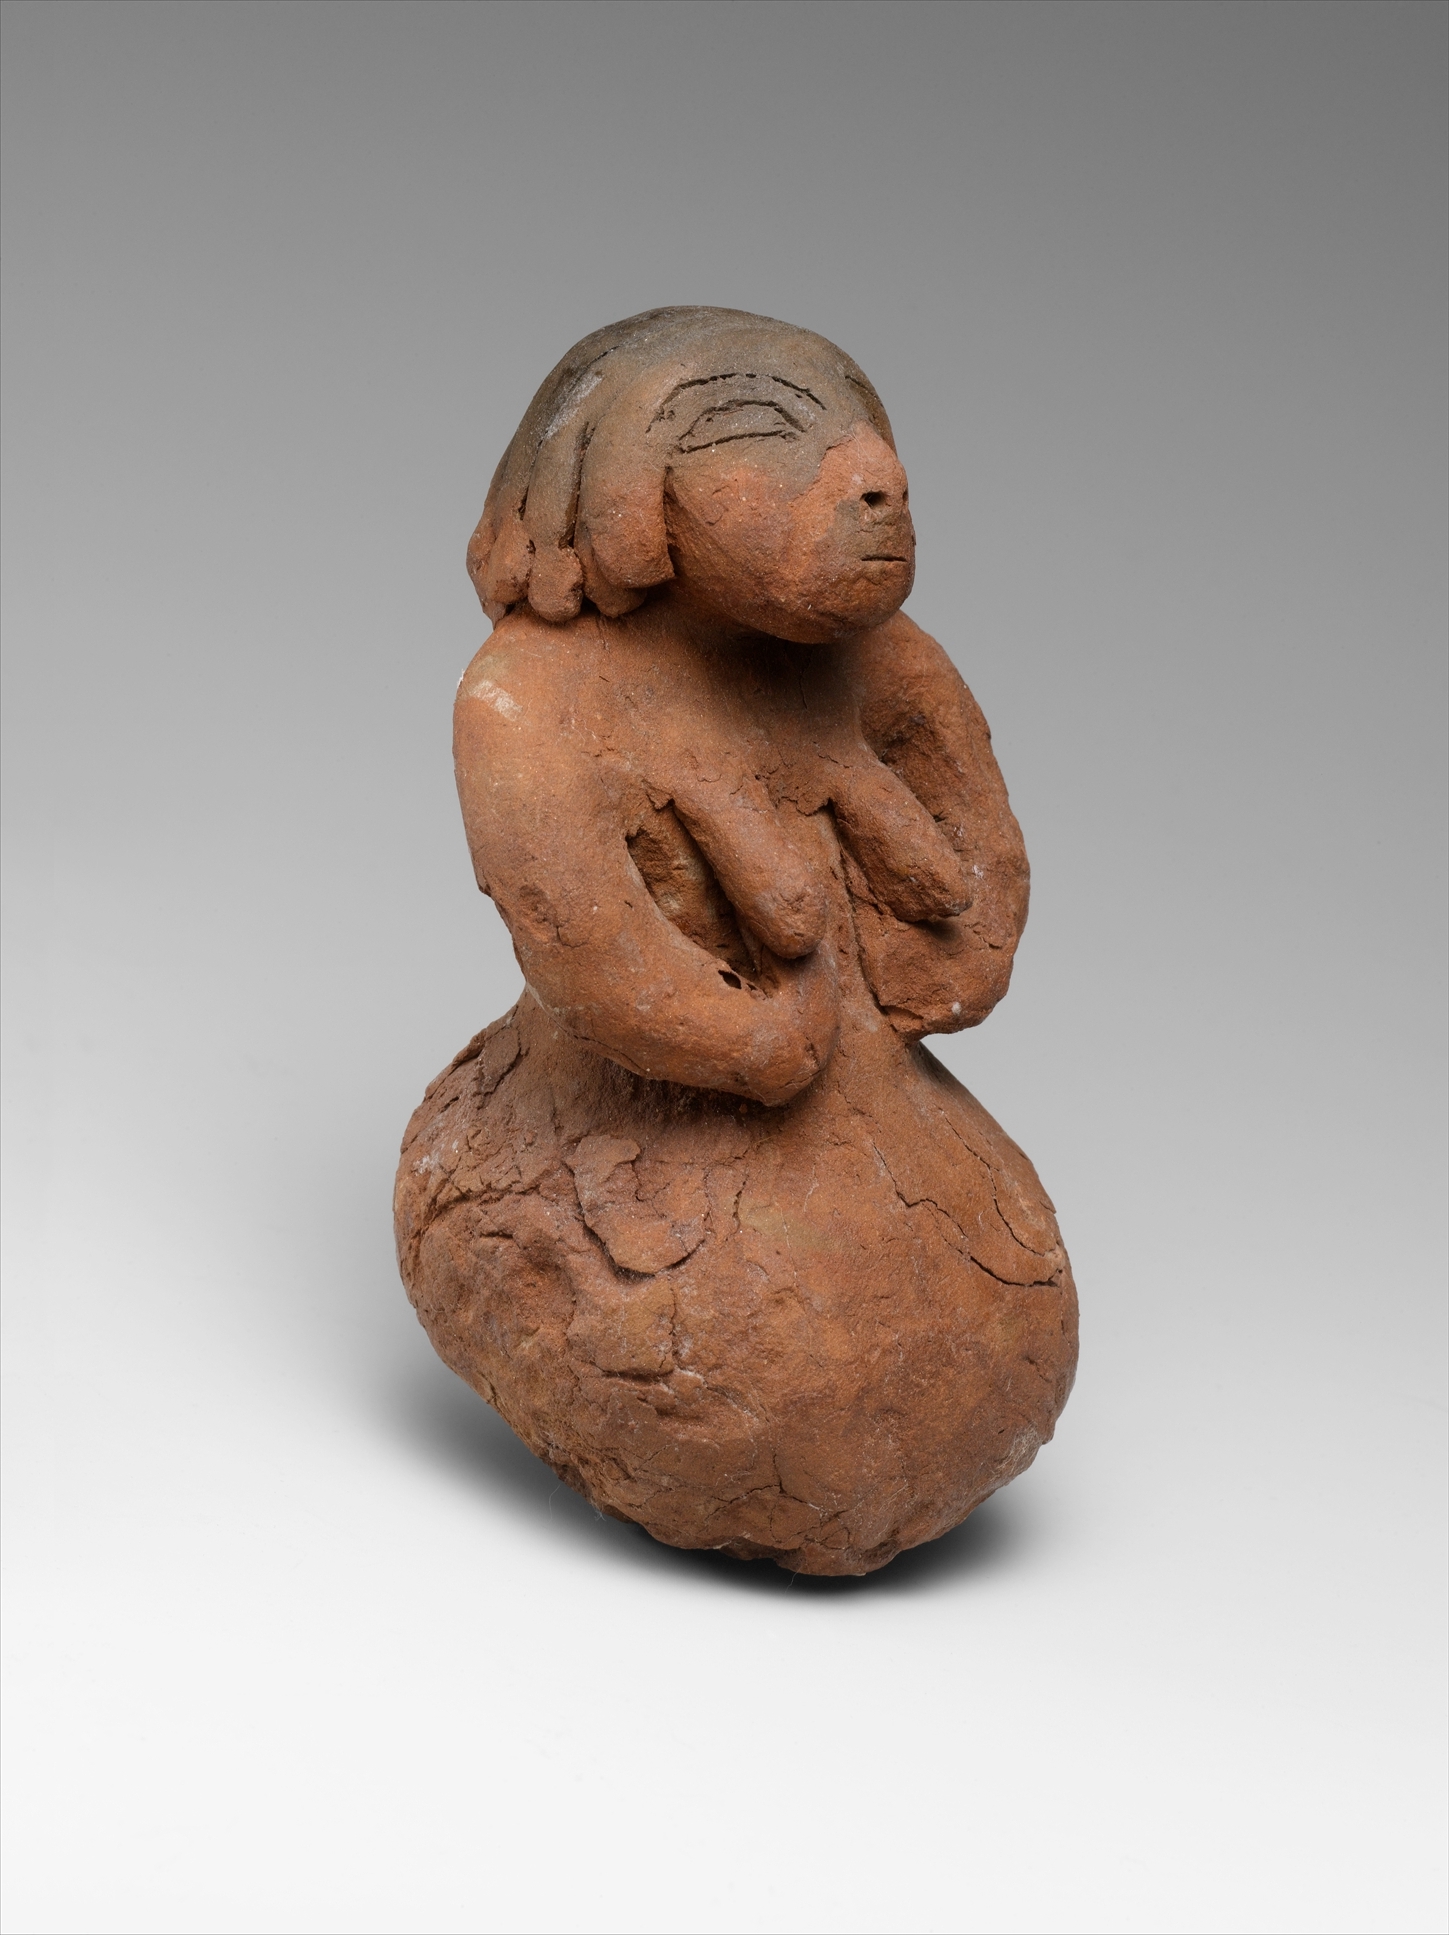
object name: figurine, seated woman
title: Figurine of a Seated Woman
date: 3450-3200 BCE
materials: pottery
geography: egypt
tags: women